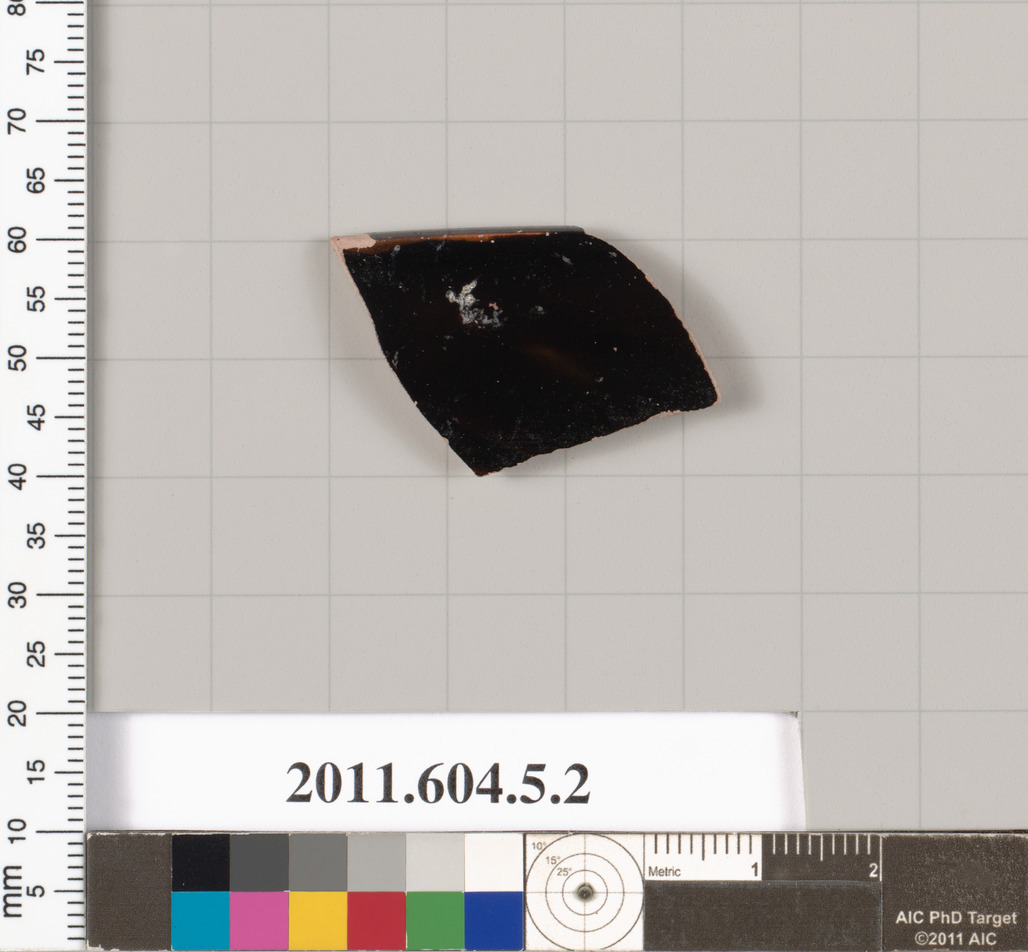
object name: kylix fragment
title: Terracotta rim fragment of a kylix (drinking cup)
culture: greek, attic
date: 490-480 BCE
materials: terracotta